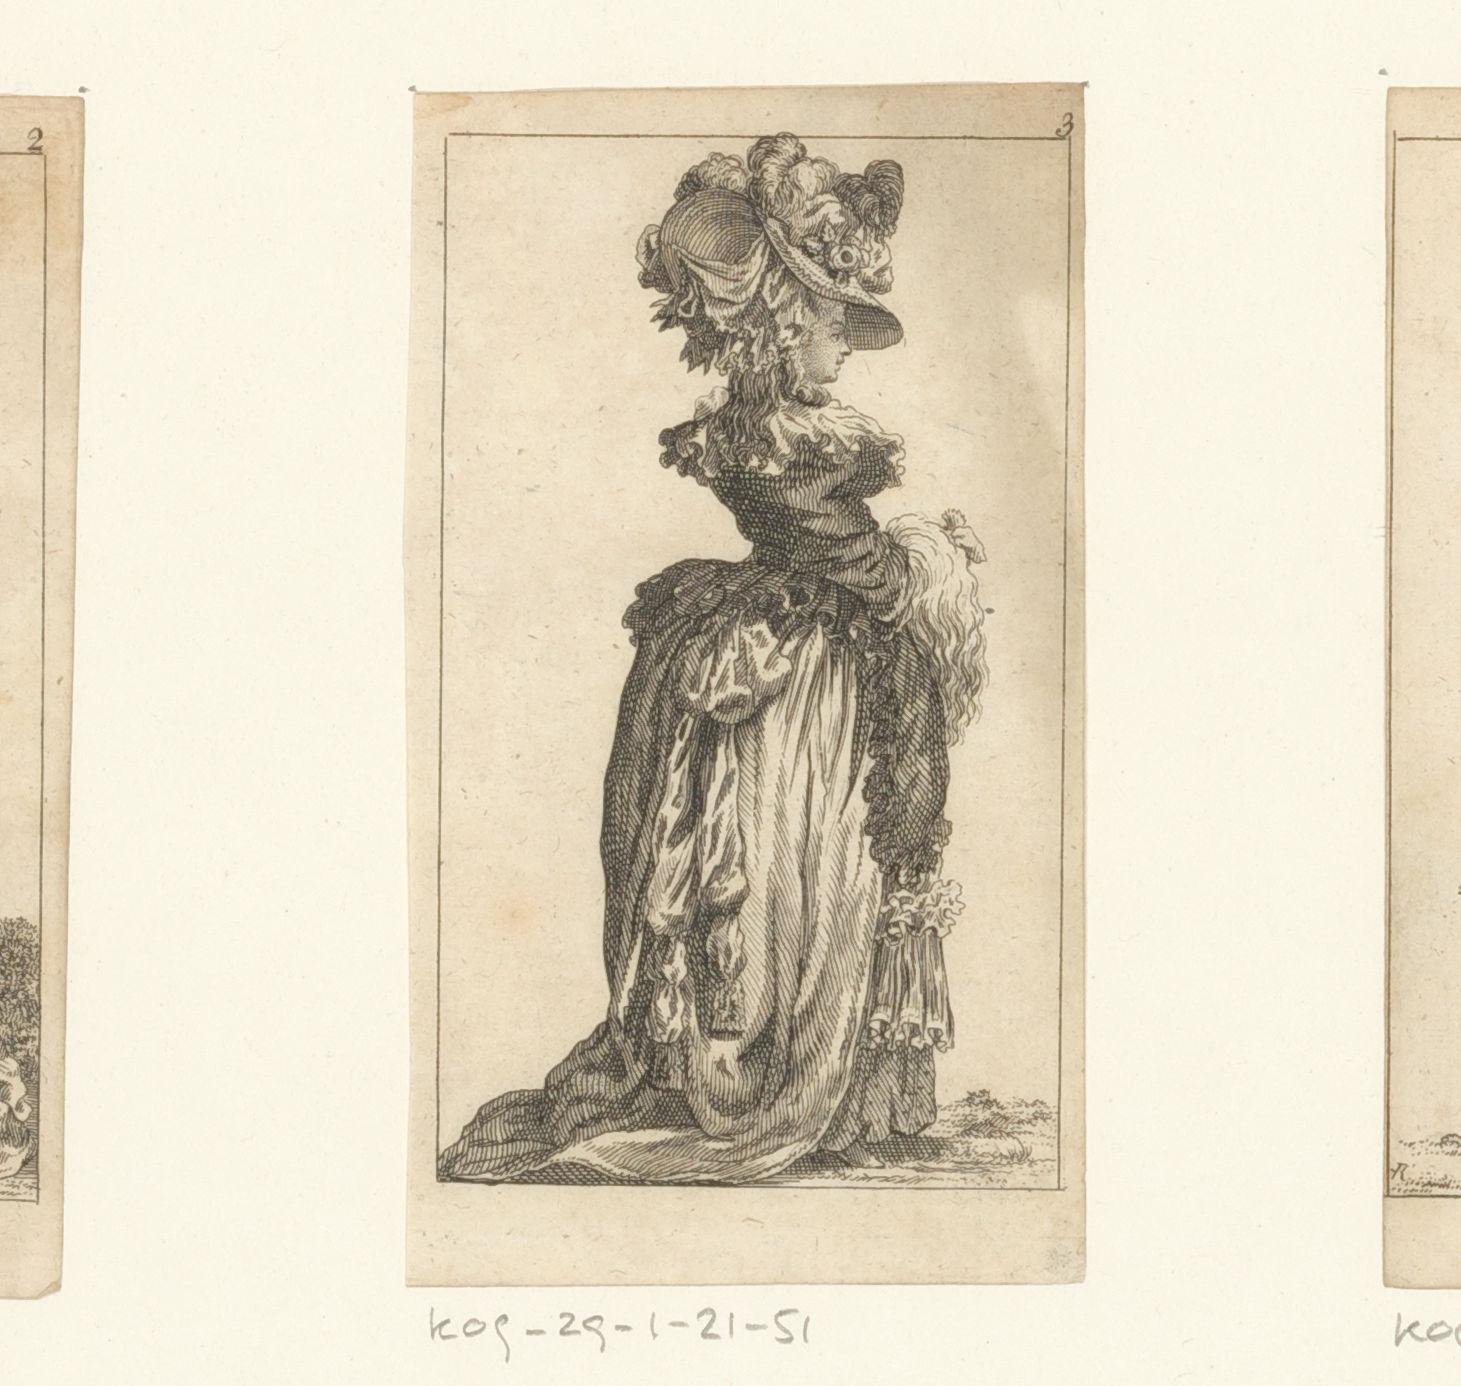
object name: print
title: Staande vrouw met mof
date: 1780-1840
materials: paper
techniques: etching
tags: muff, head-gear: hat, dress, gown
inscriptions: stamp, collector's mark: Lugt 1641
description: Rechtsboven genummerd: 3. Onderwerpsrubrieken binnen de Atlas Zeden en Gewoonten: Zeden en Gewoonten in Engeren Zin, De Kleeding, Kleederdrachten (tijdvakken), De 18de eeuw (de pruikentijd). Mannen en vrouwen.